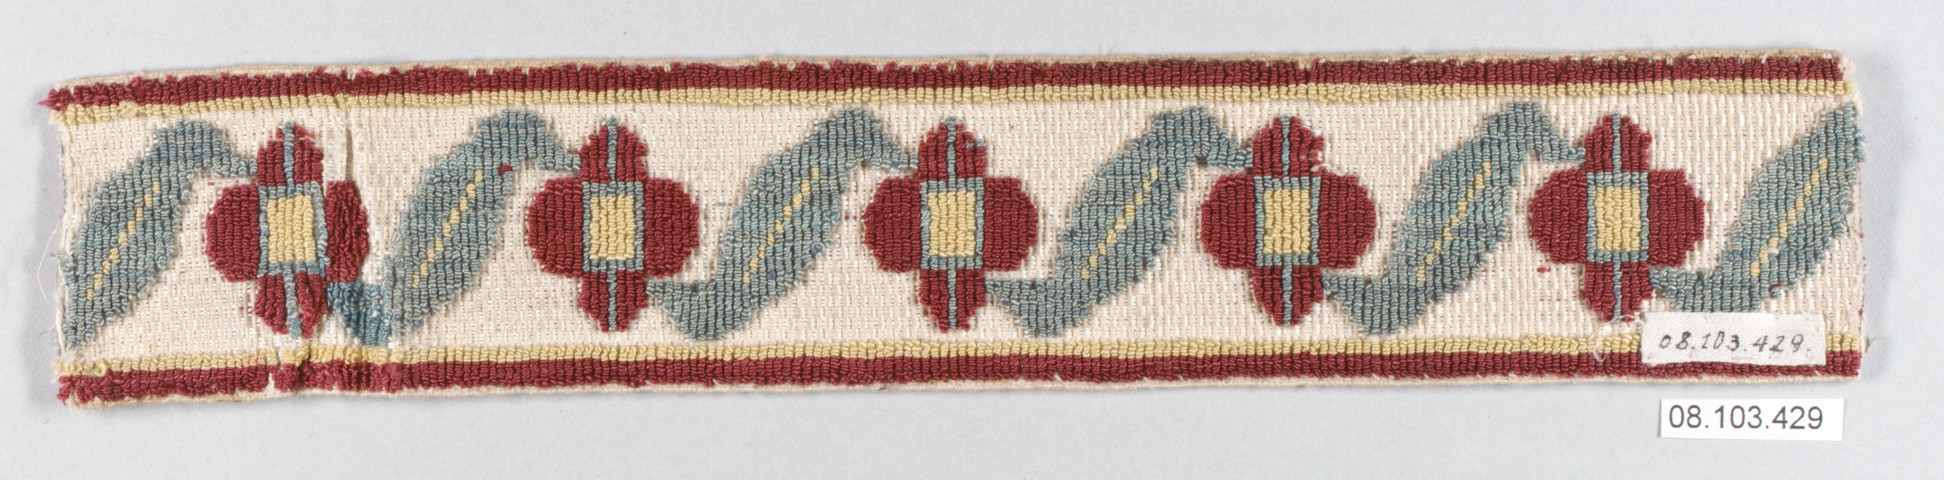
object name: galloon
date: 1701-1900